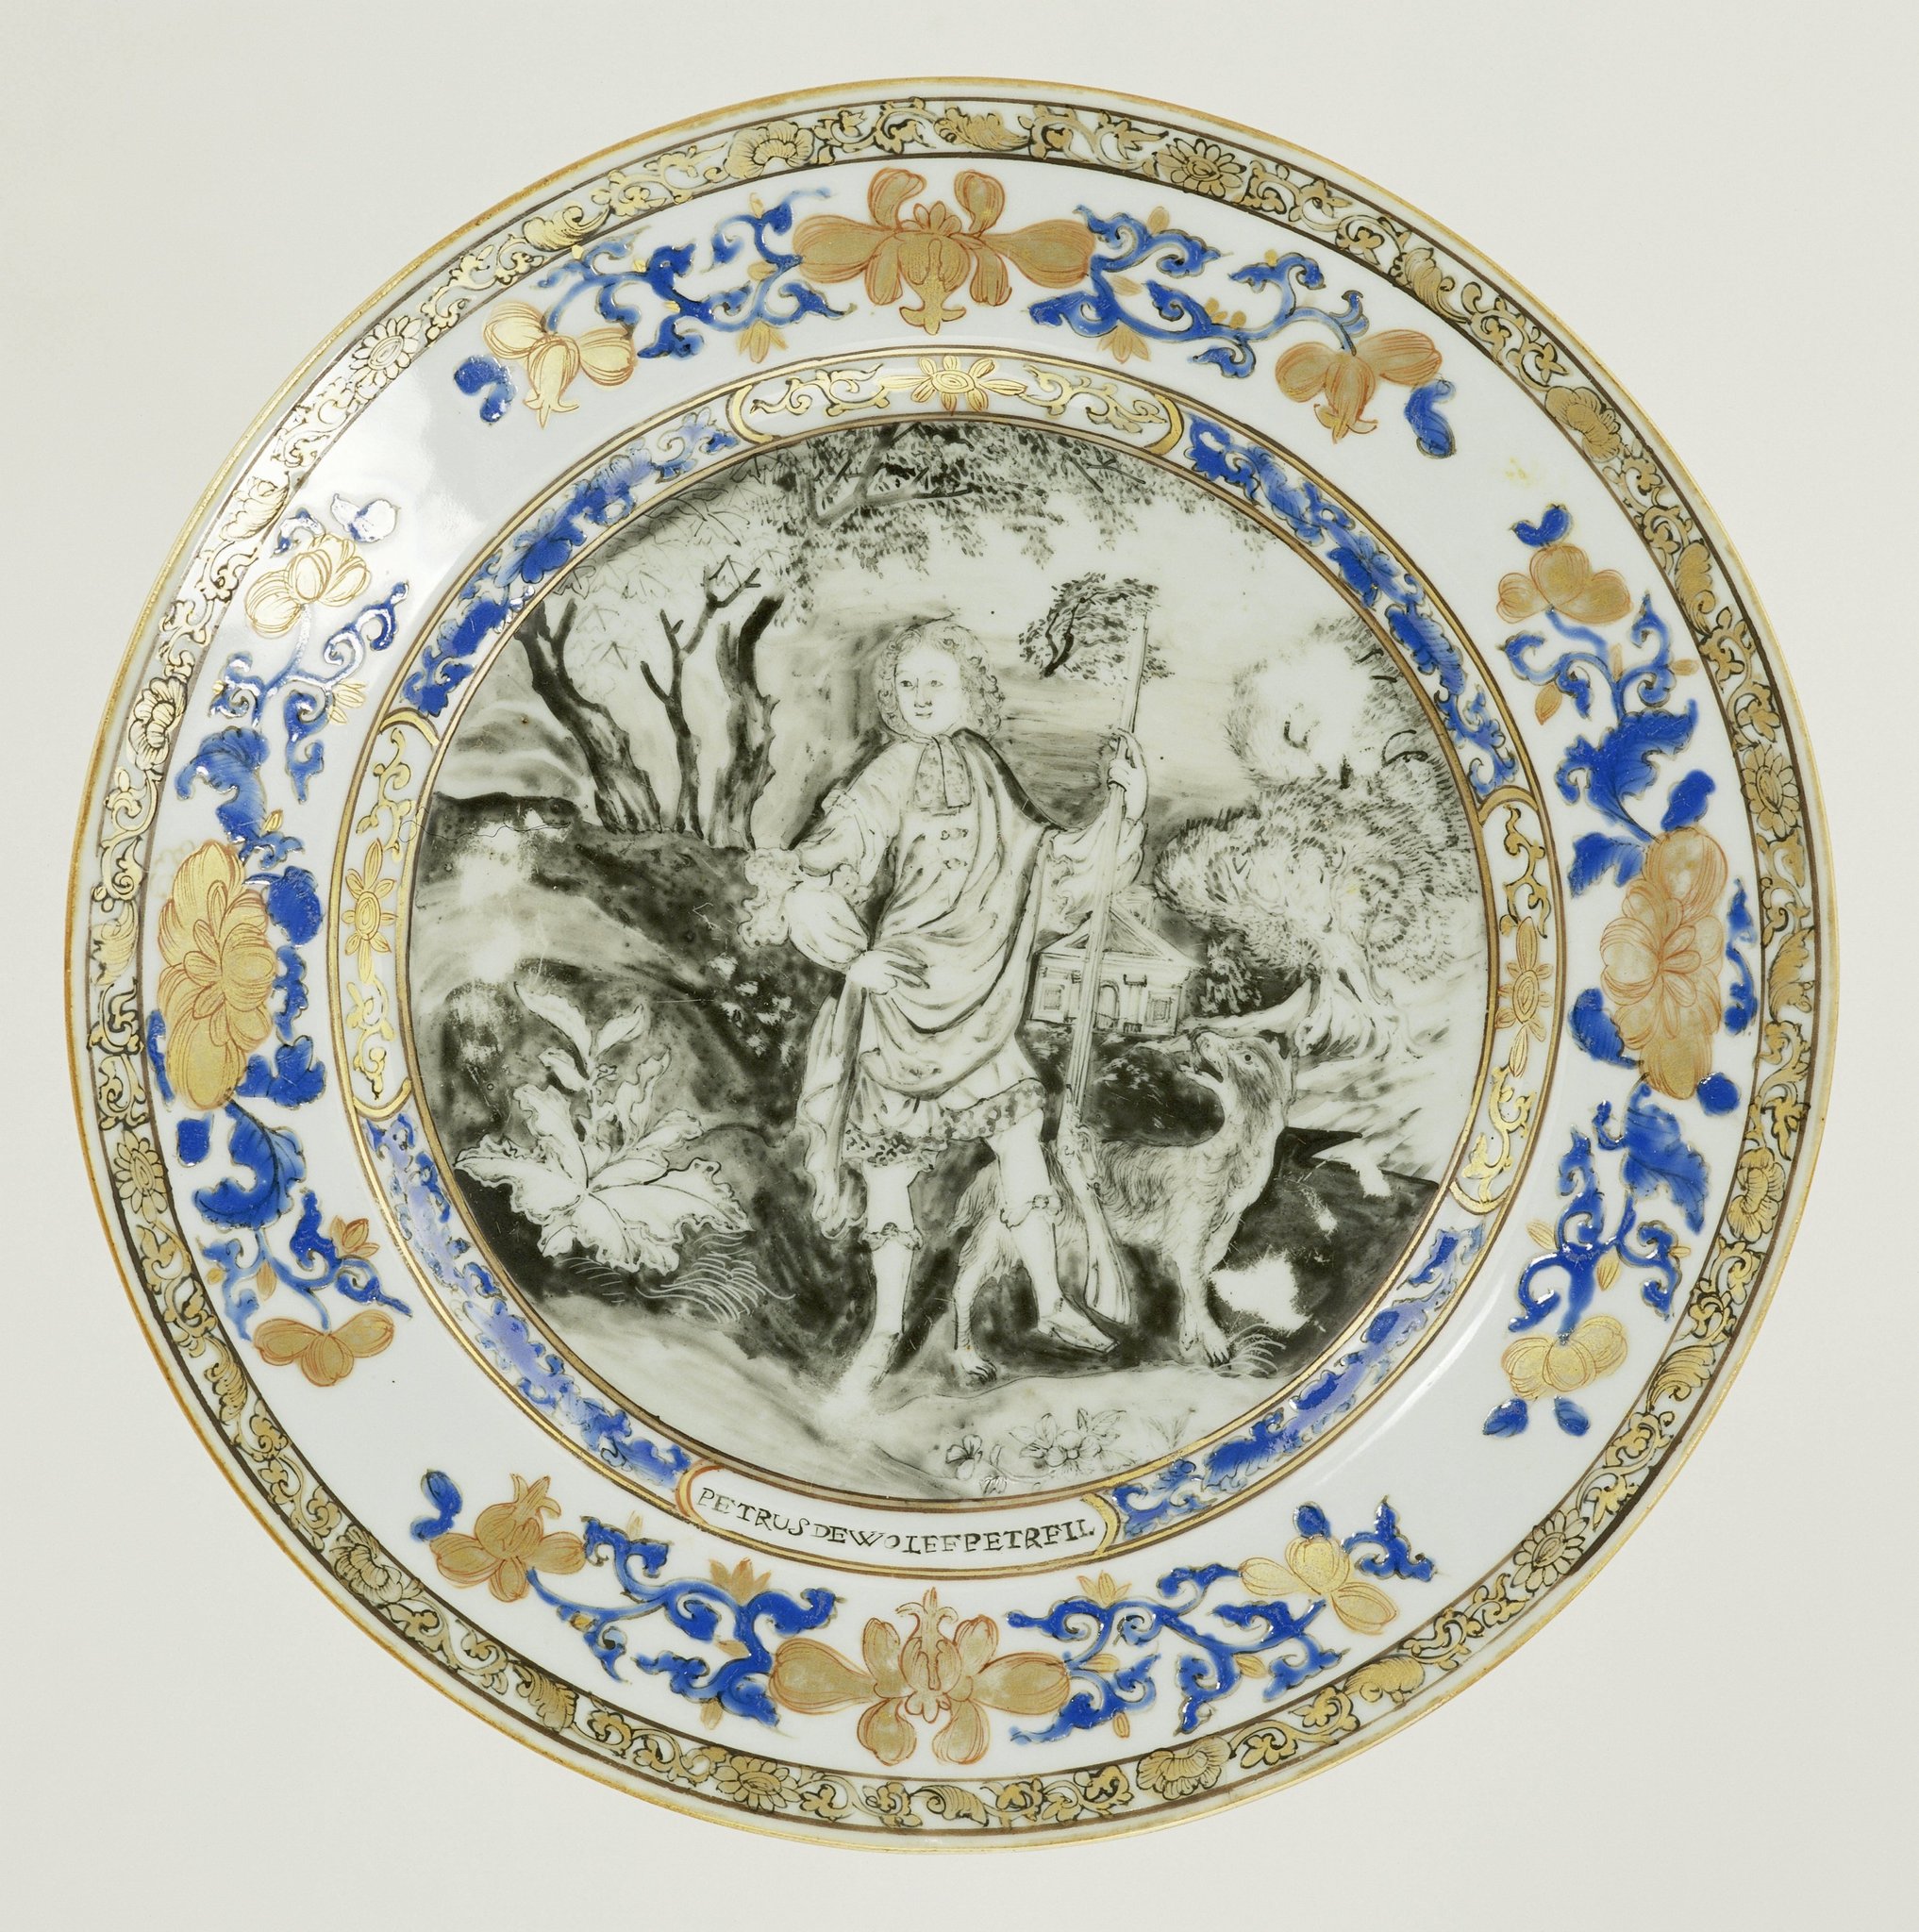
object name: plate dish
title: Plate with a portrait of Petrus de Wolff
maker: pieter schenk (i)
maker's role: print maker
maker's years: 1660-1711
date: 1725-1749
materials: glaze, gold, paint, porcelain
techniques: firing, gilding, turning, vitrification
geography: england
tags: petrus de wolff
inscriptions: inscription: ‘PETRUS DE WOLFF PETR FIL’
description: Bord op een voetring, gedecoreerd in encre de Chine met de emailkleuren blauw en goud. Centraal staat een voorstelling van een jongeman met in zijn rechterhand een geweer dat op de grond steunt. Links van de jongeman is een hond afgebeeld die naar hem opkijkt. Zij bevinden zich in een landschappelijke, bosrijke omgeving, met op de achtergrond een huis. Onder aan de voorstelling is in de rand een inscriptie te zien met de woorden: PETRUS DE WOLFF PETR FIL. De Wolff was historicus en schrijver van 'The General History of the Jesuits' (1789). De voorstelling op het porselein is geschilderd naar een prent van Pieter Schenk (1660-1718). Schenk maakte de gravure naar een mezzo-tint door John Smith, die zich weer liet inspireren door een schilderij van William Wissing (1658-1687). Van deze afbeelding van Petrus de Wolff, vervaardigd door Schenk, bestaat nog een ‘companion print’. Het is een voorstelling van zijn broer Johannes de Wolff. Ook deze persoon bevindt zich in een bosrijke omgeving, terwijl hij met zijn linkerarm achterwaarts op een huis wijst. Ook deze voorstelling is afgebeeld op porselein.